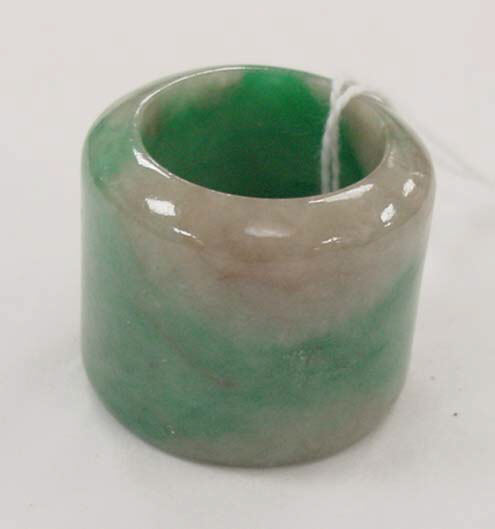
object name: ring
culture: chinese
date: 1801-1900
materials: jade